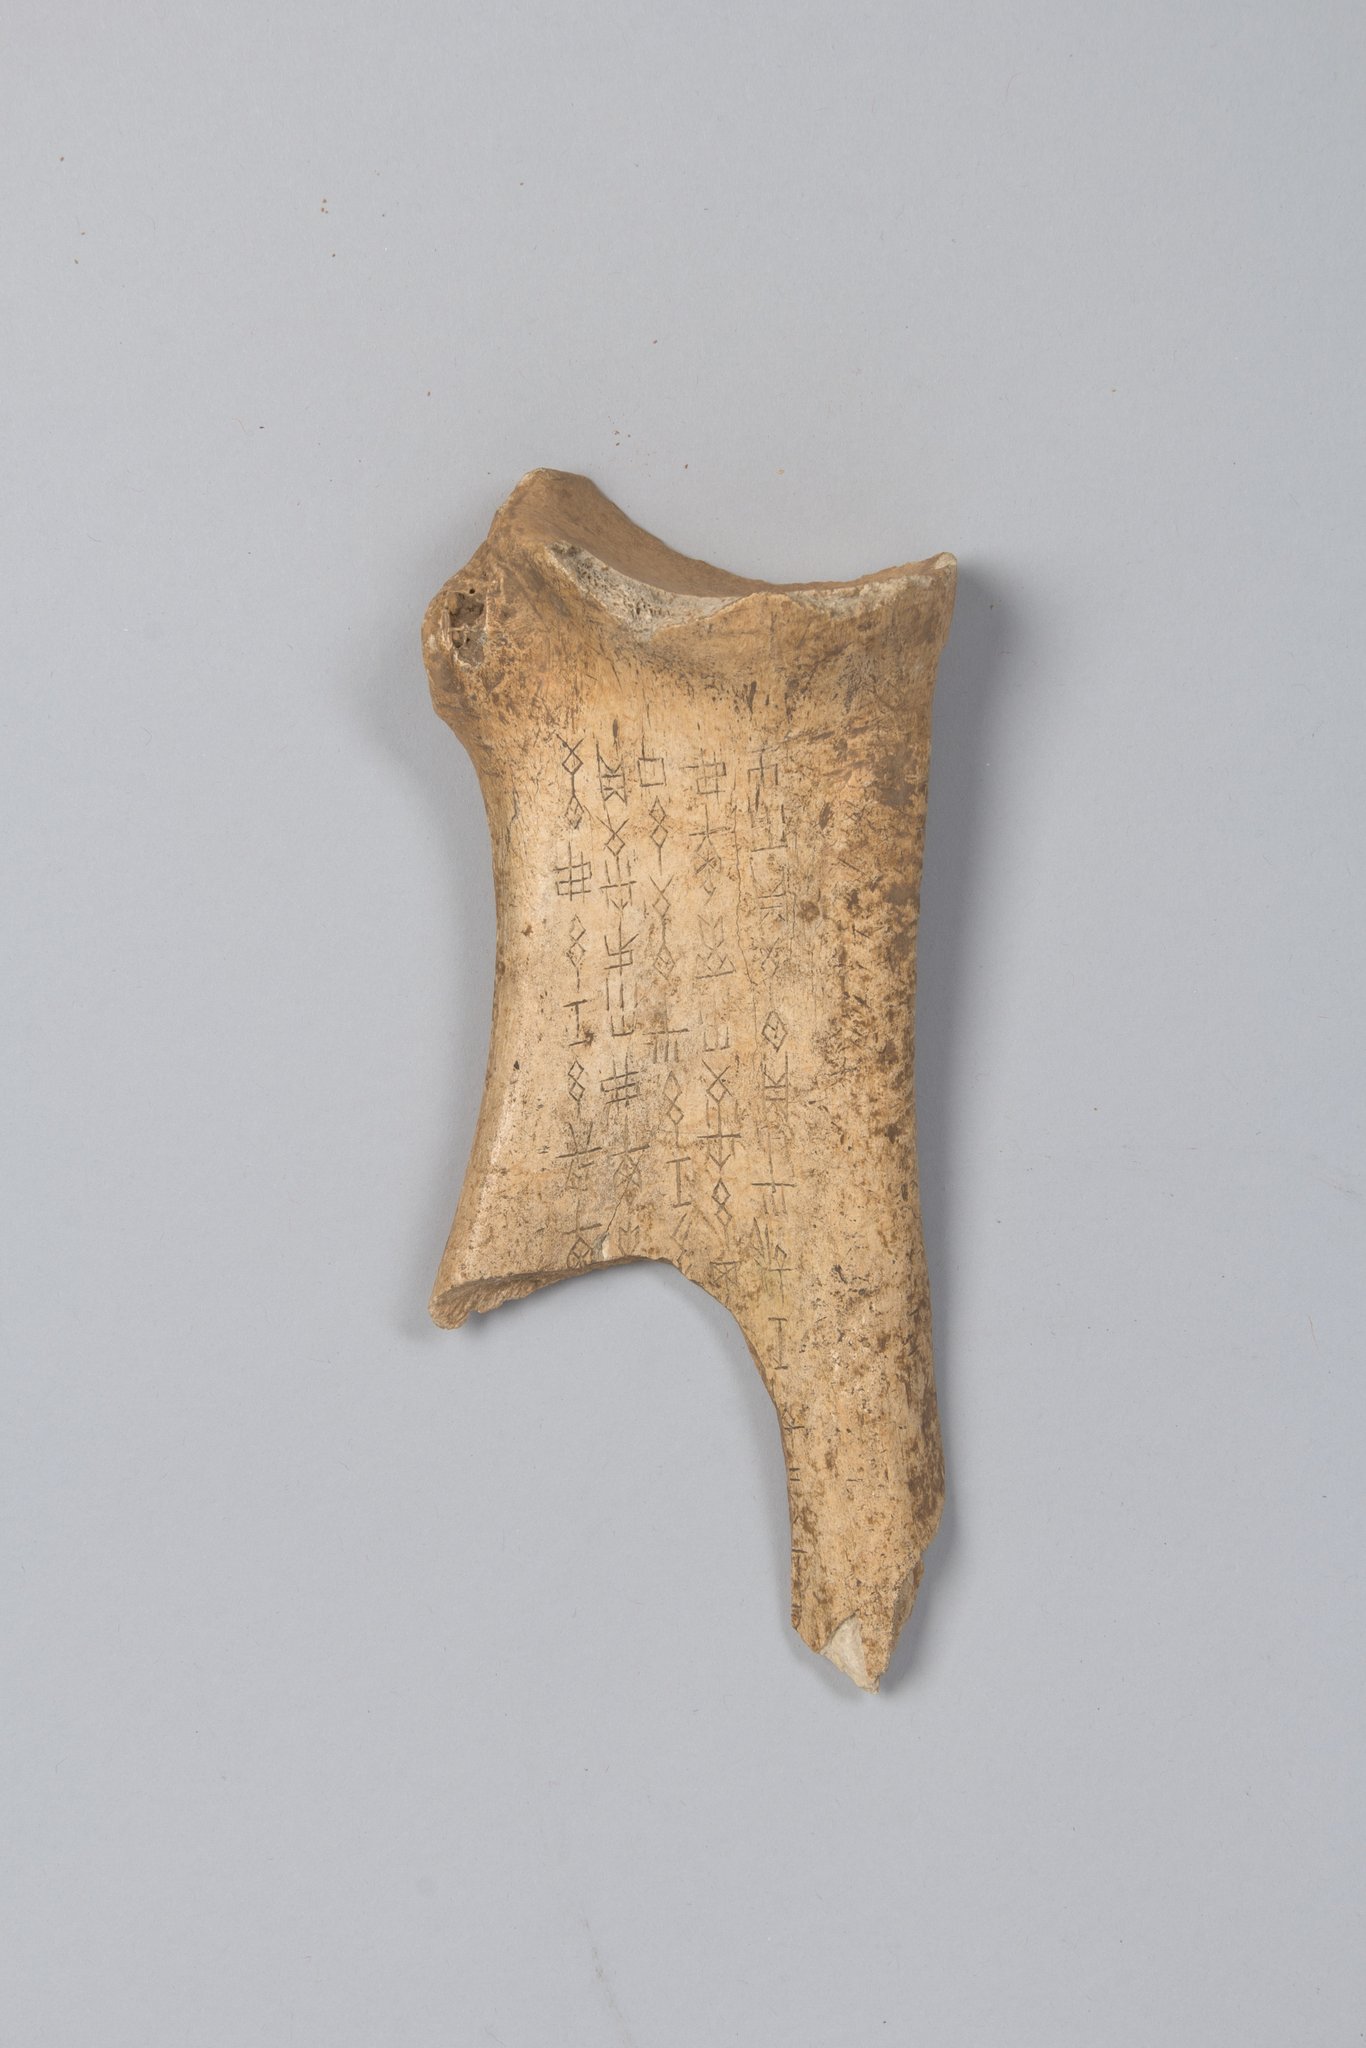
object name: oracle bone fragment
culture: chinese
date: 1610-1036 BCE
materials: bone